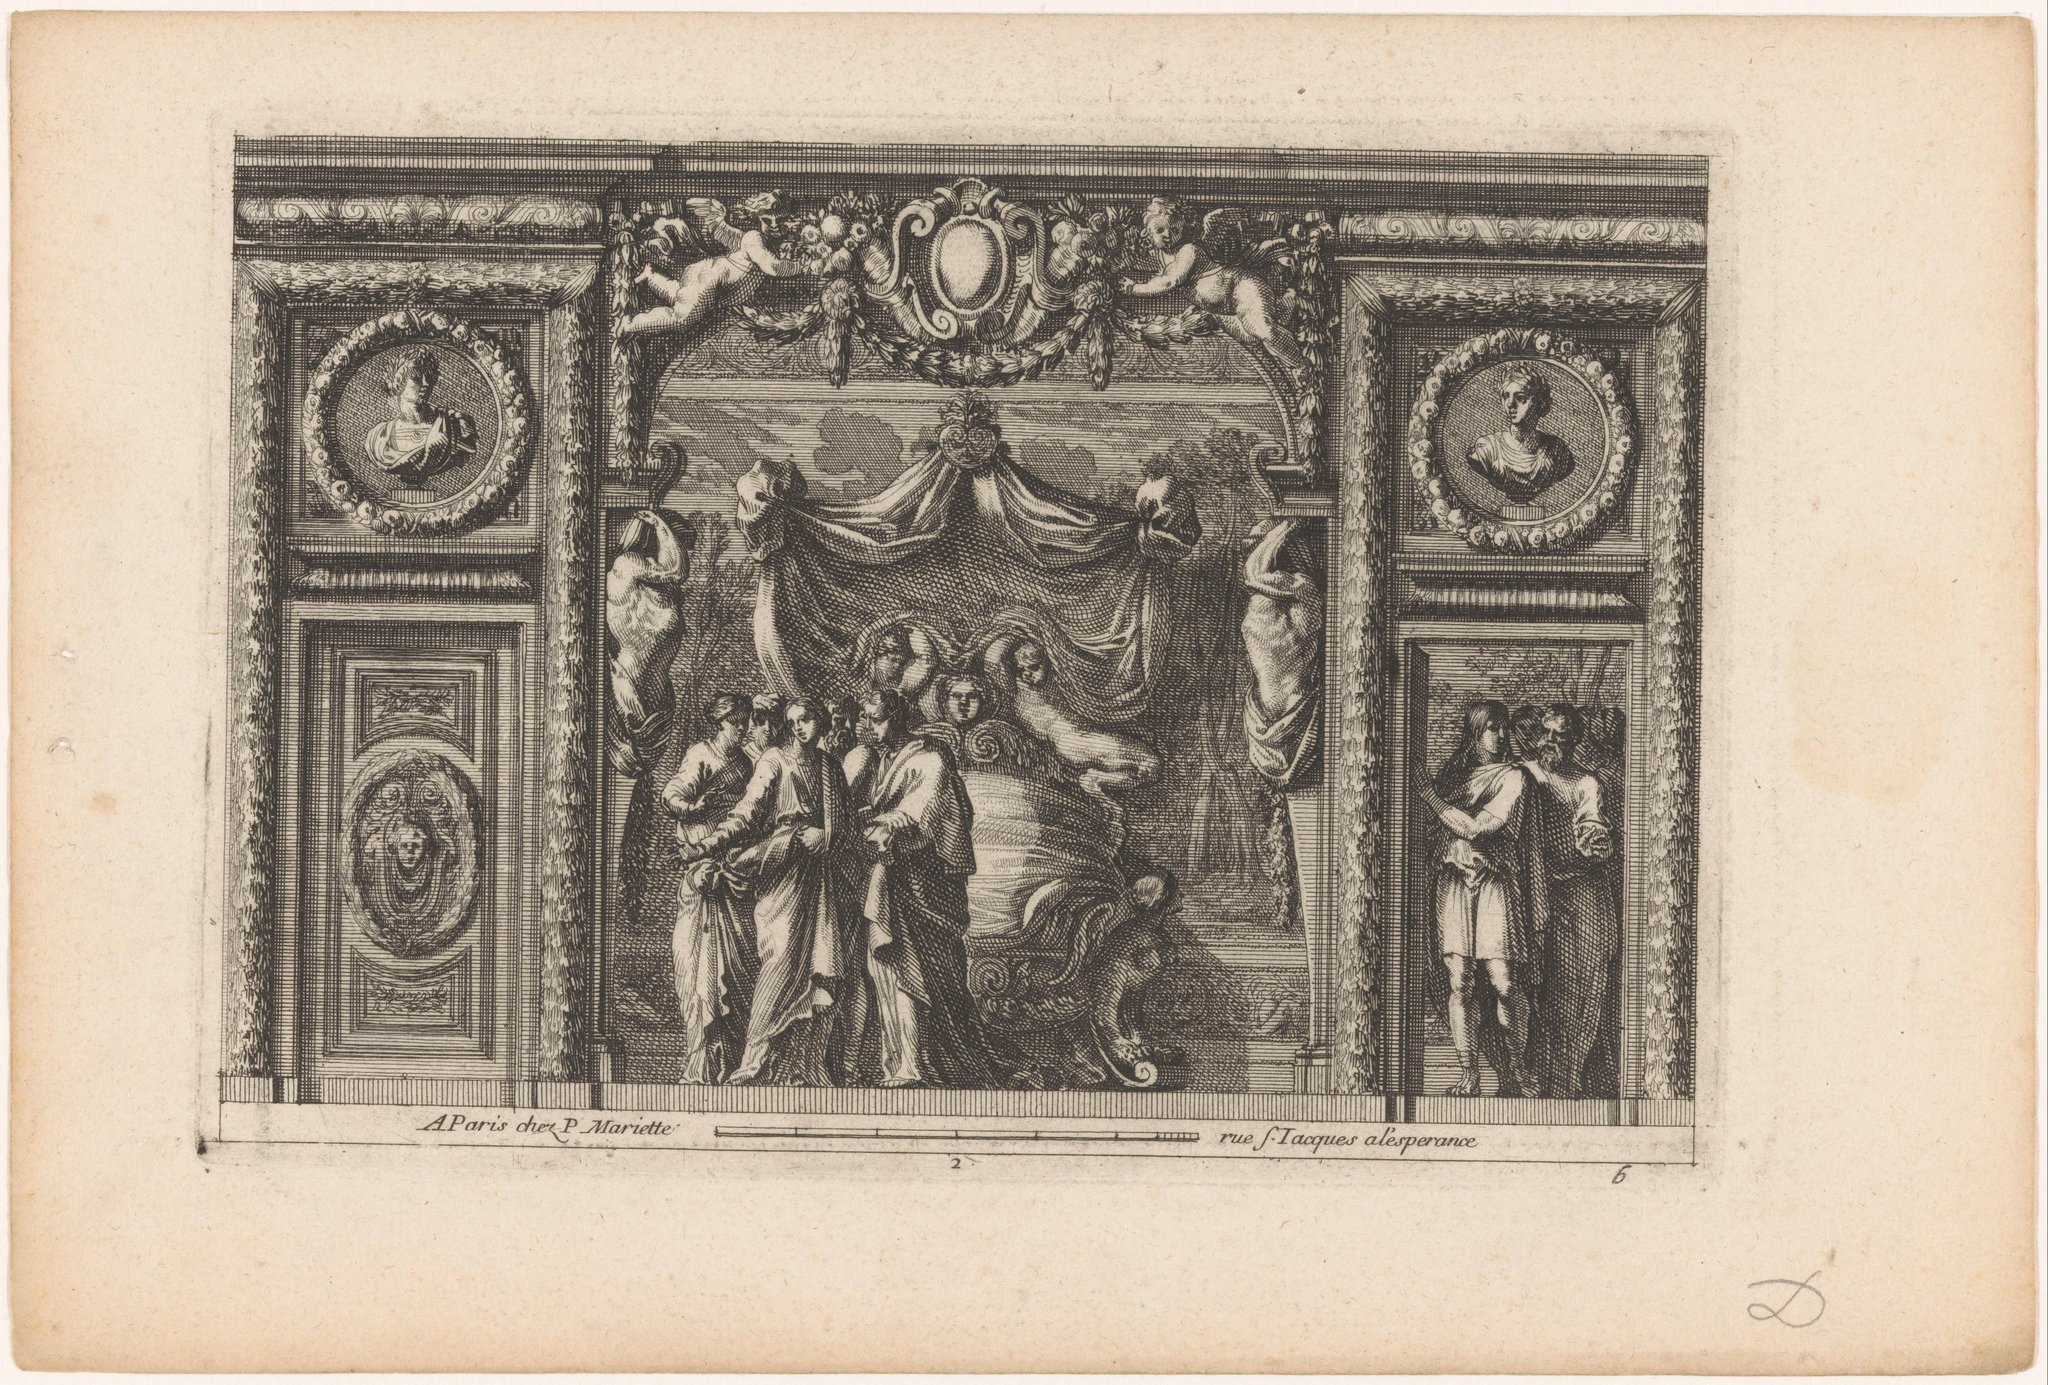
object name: print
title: Alkoof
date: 1657-1716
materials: paper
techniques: etching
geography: paris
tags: (story of) the emperor titus - love-affairs of person from classical history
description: Alkoof met een groep staand voor een bed geflankeerd door twee termen en twee deuren met daarboven medaillons met keizersportretten. Mogelijk het verhaal van Titus en Berenice. Rechts onder 6 genummerd.